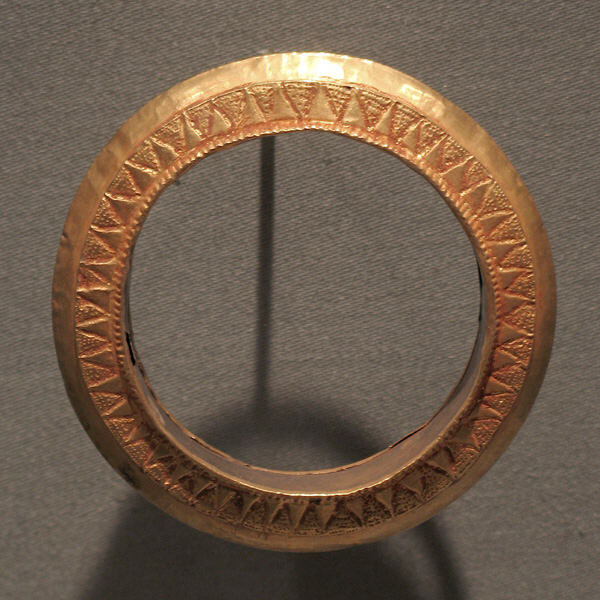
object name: anklet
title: Anklet with Repeated Incised and Stippled Pattern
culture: indonesian, javanese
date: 701-933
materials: gold